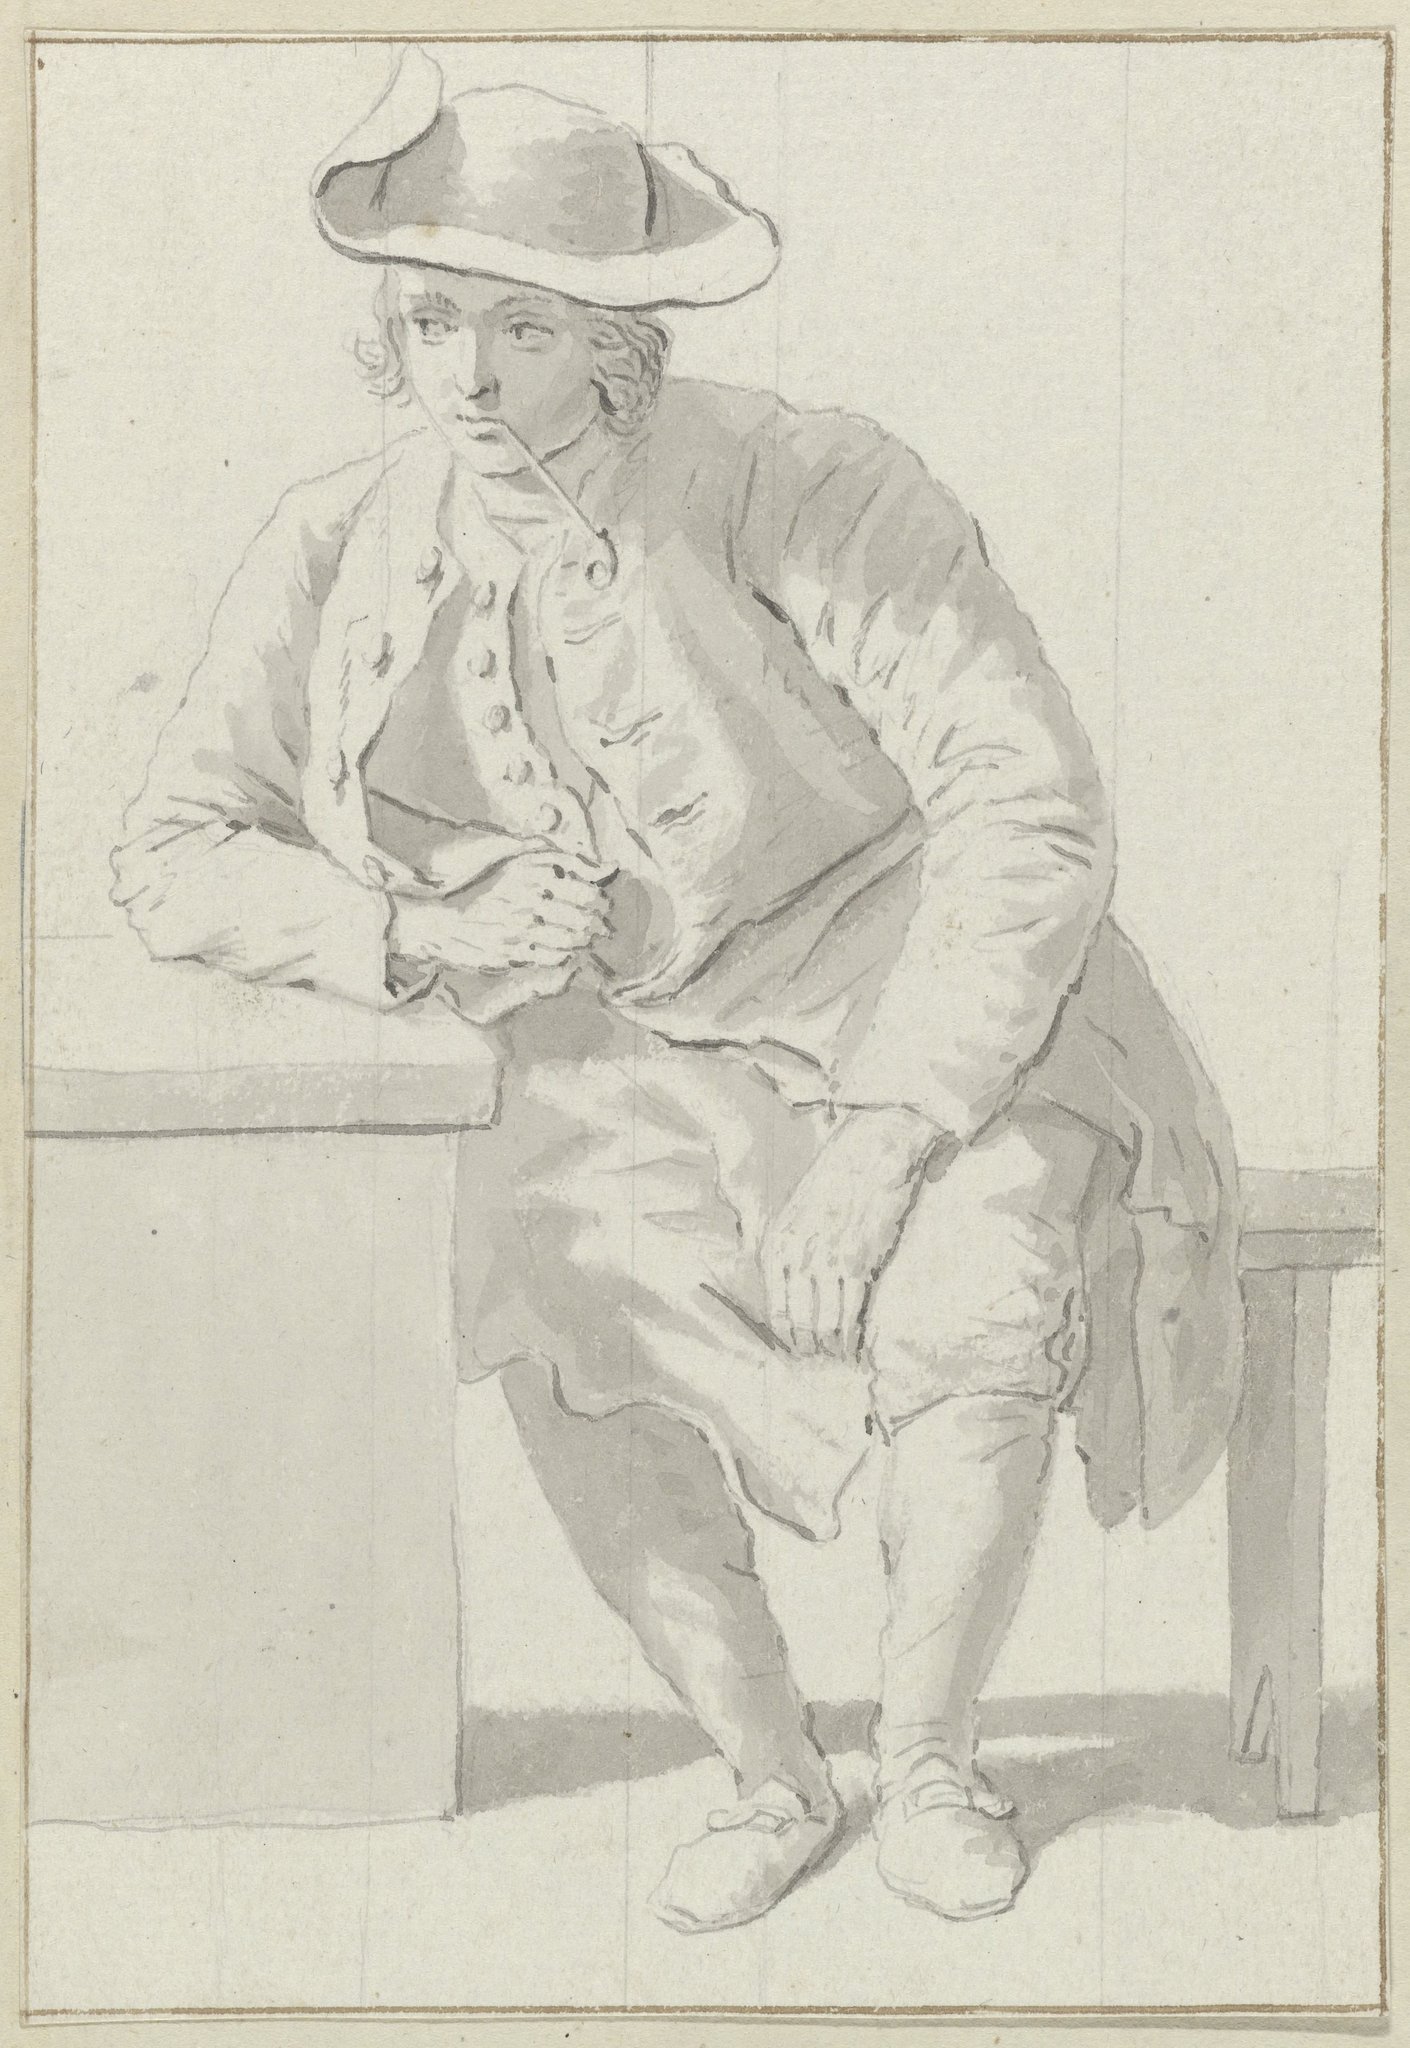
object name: drawing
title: Pijprokende man met hoed op een bank, leunend op tafel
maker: Anonymous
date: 1700-1799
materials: ink, paper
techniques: brush, pen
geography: netherlands